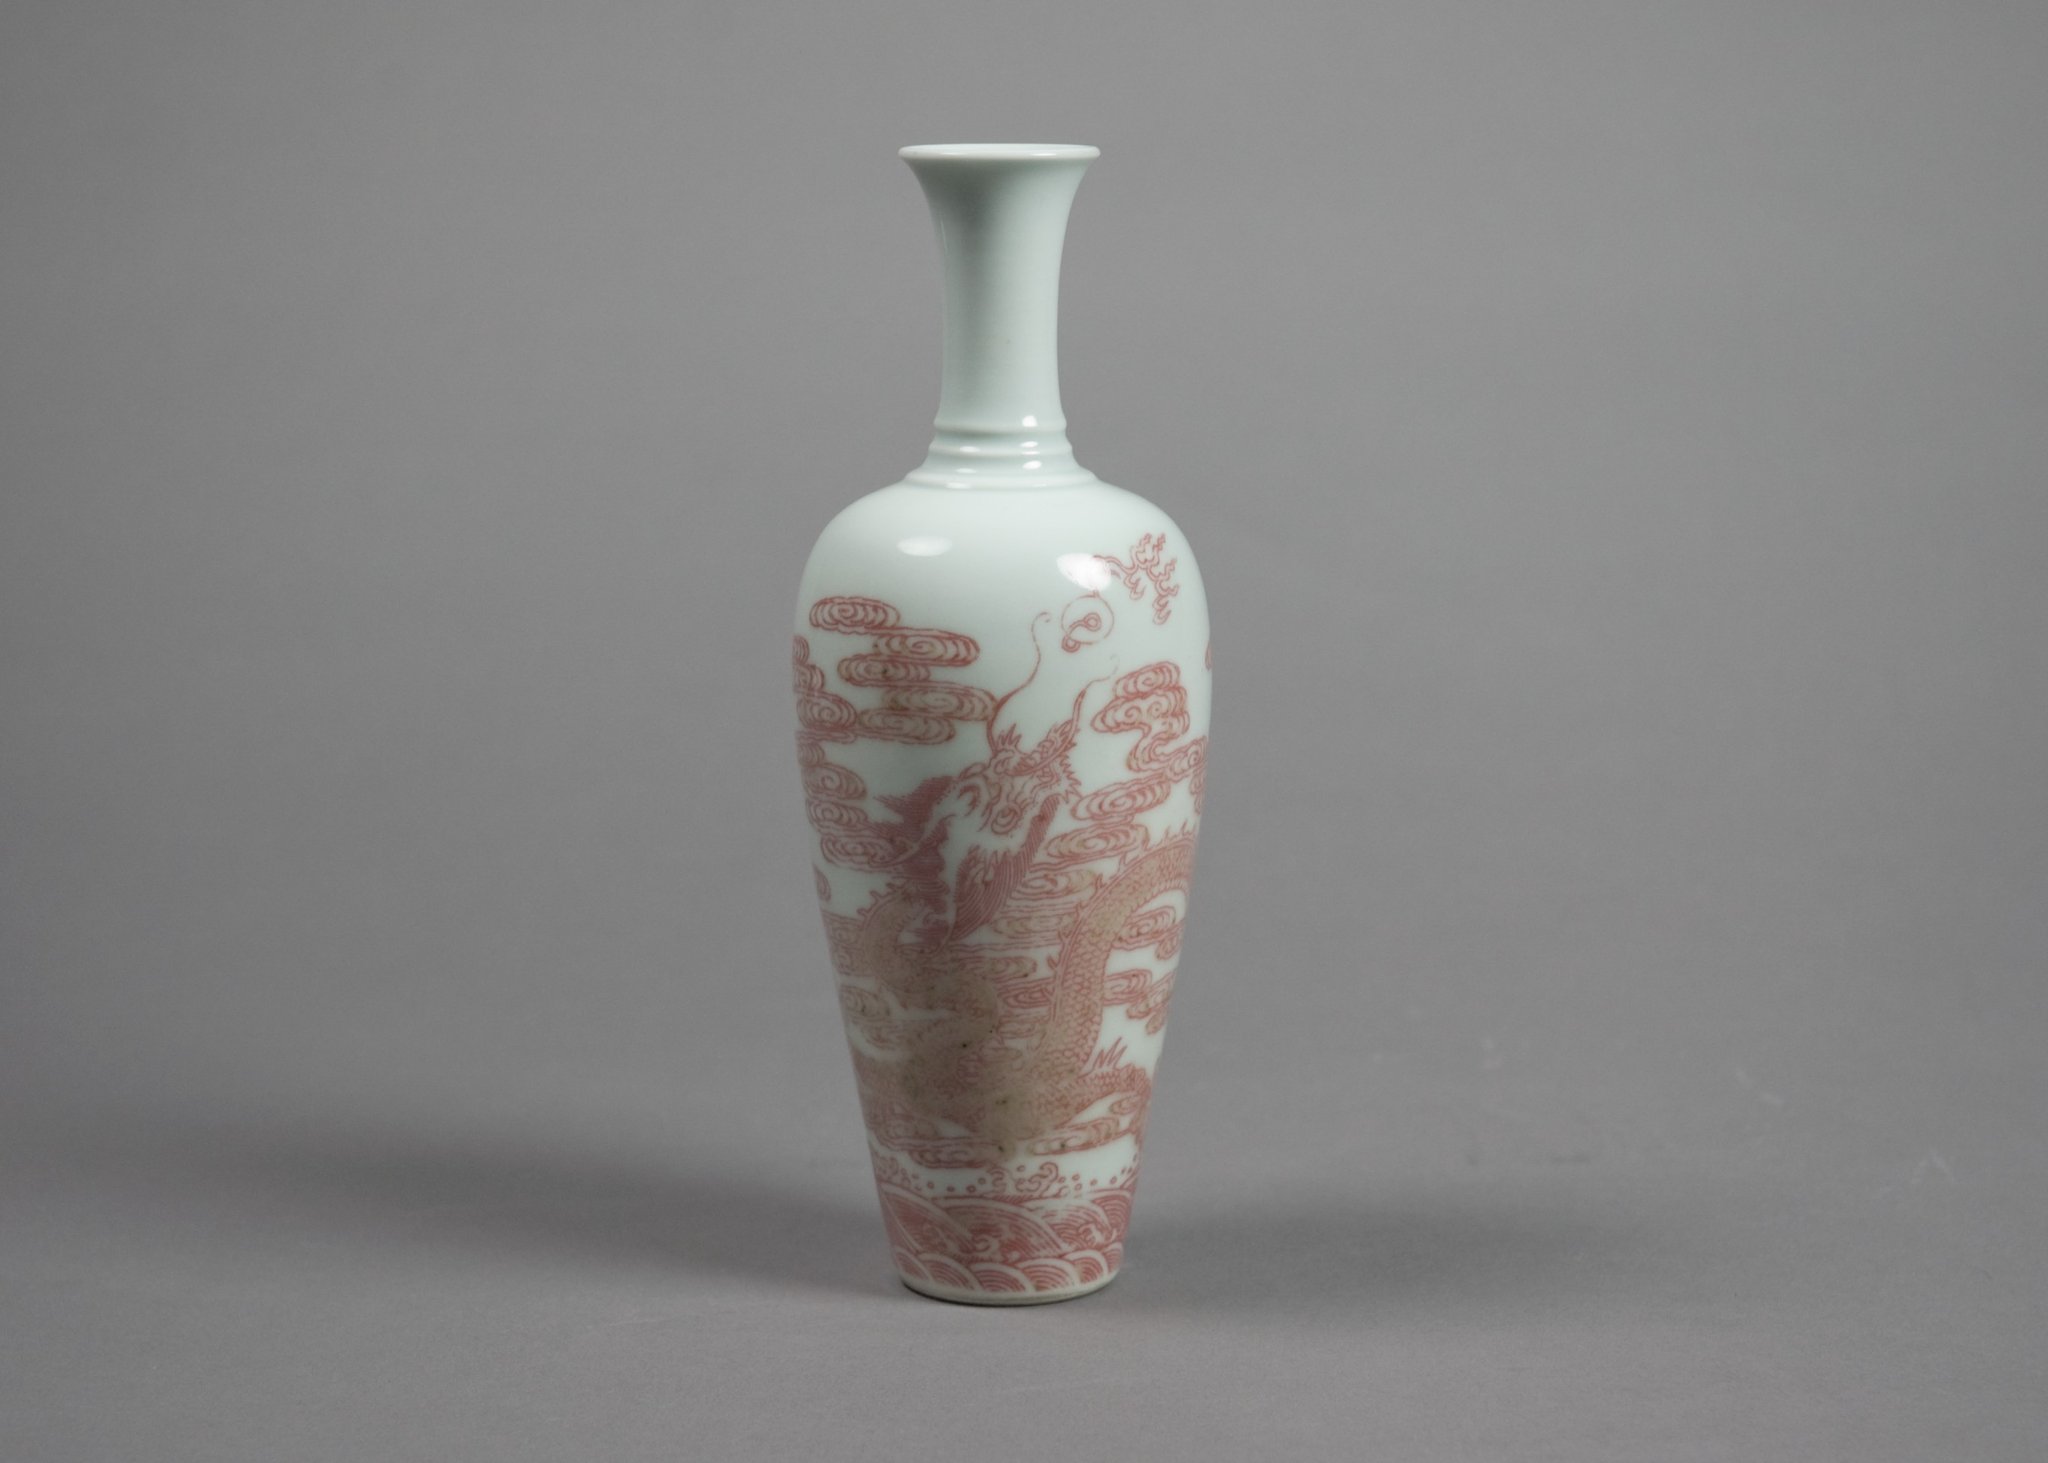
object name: vase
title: Vase with Dragon amid Clouds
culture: chinese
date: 1701-1733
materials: copper, glaze, porcelain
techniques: painting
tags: dragons